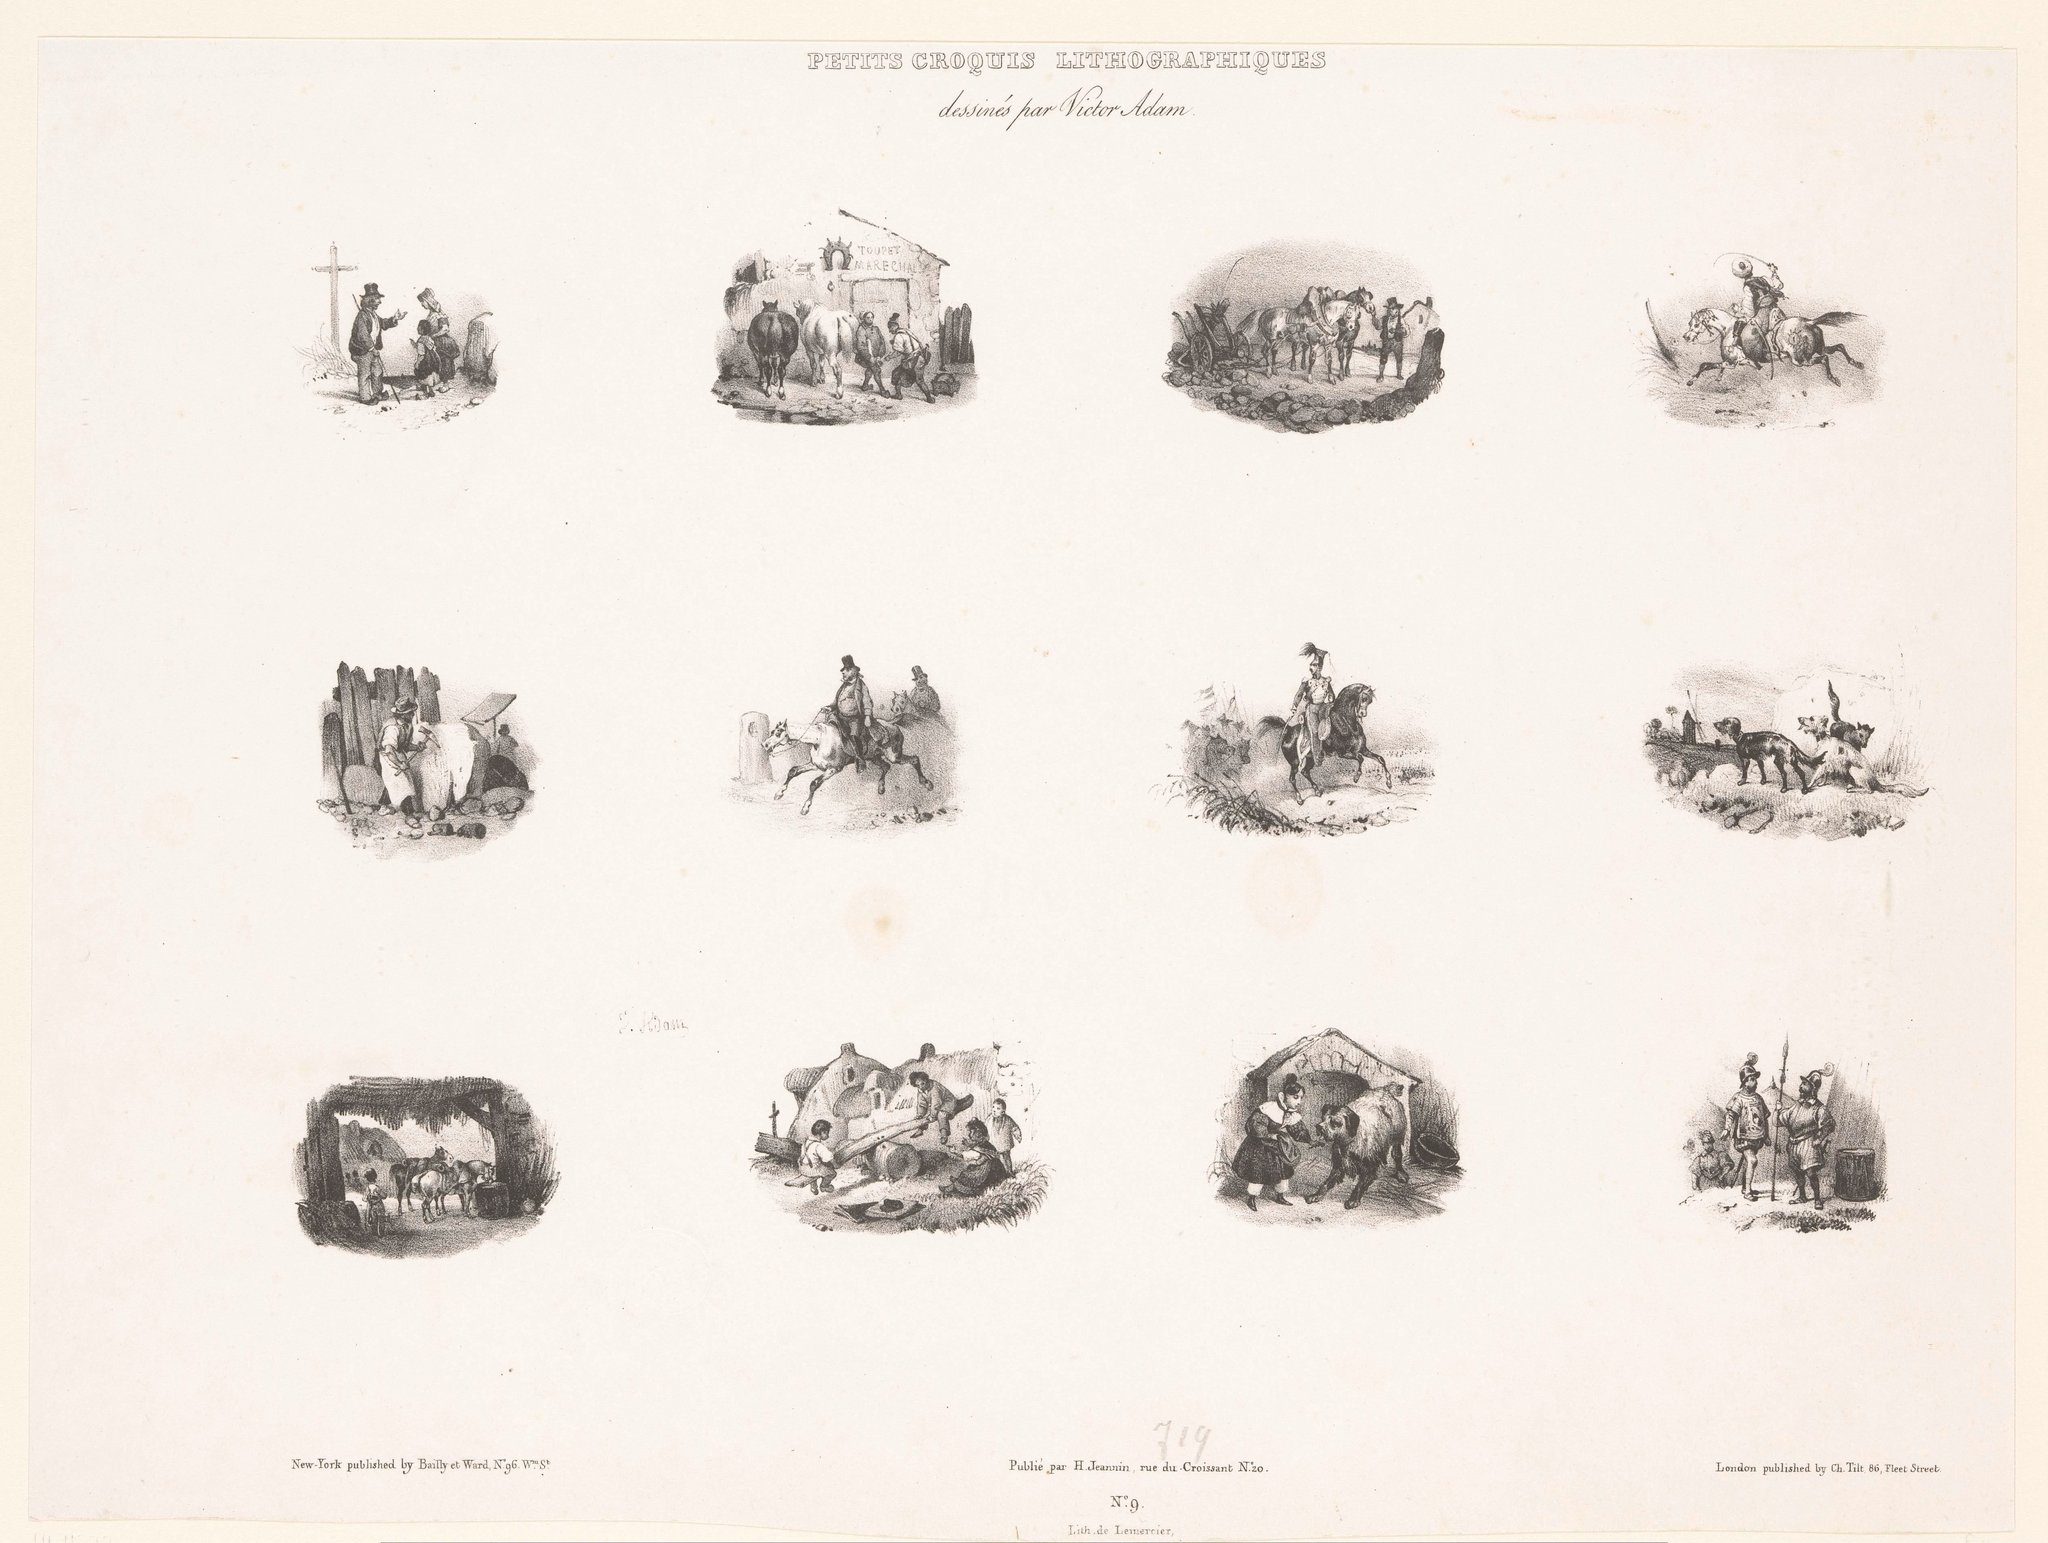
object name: print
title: Twaalf voorstellingen van menselijke activiteiten en dieren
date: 1832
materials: paper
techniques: lithograph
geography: paris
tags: riding a horse, ass, or mule; rider, horseman, crafts and industries, dog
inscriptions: annotation: ‘719’, stamp: Lugt 3987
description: Twaalf voorstellingen van dieren en verschillende soorten mensen, waaronder soldaten, kinderen, een hoefsmid en een steenhouwer.